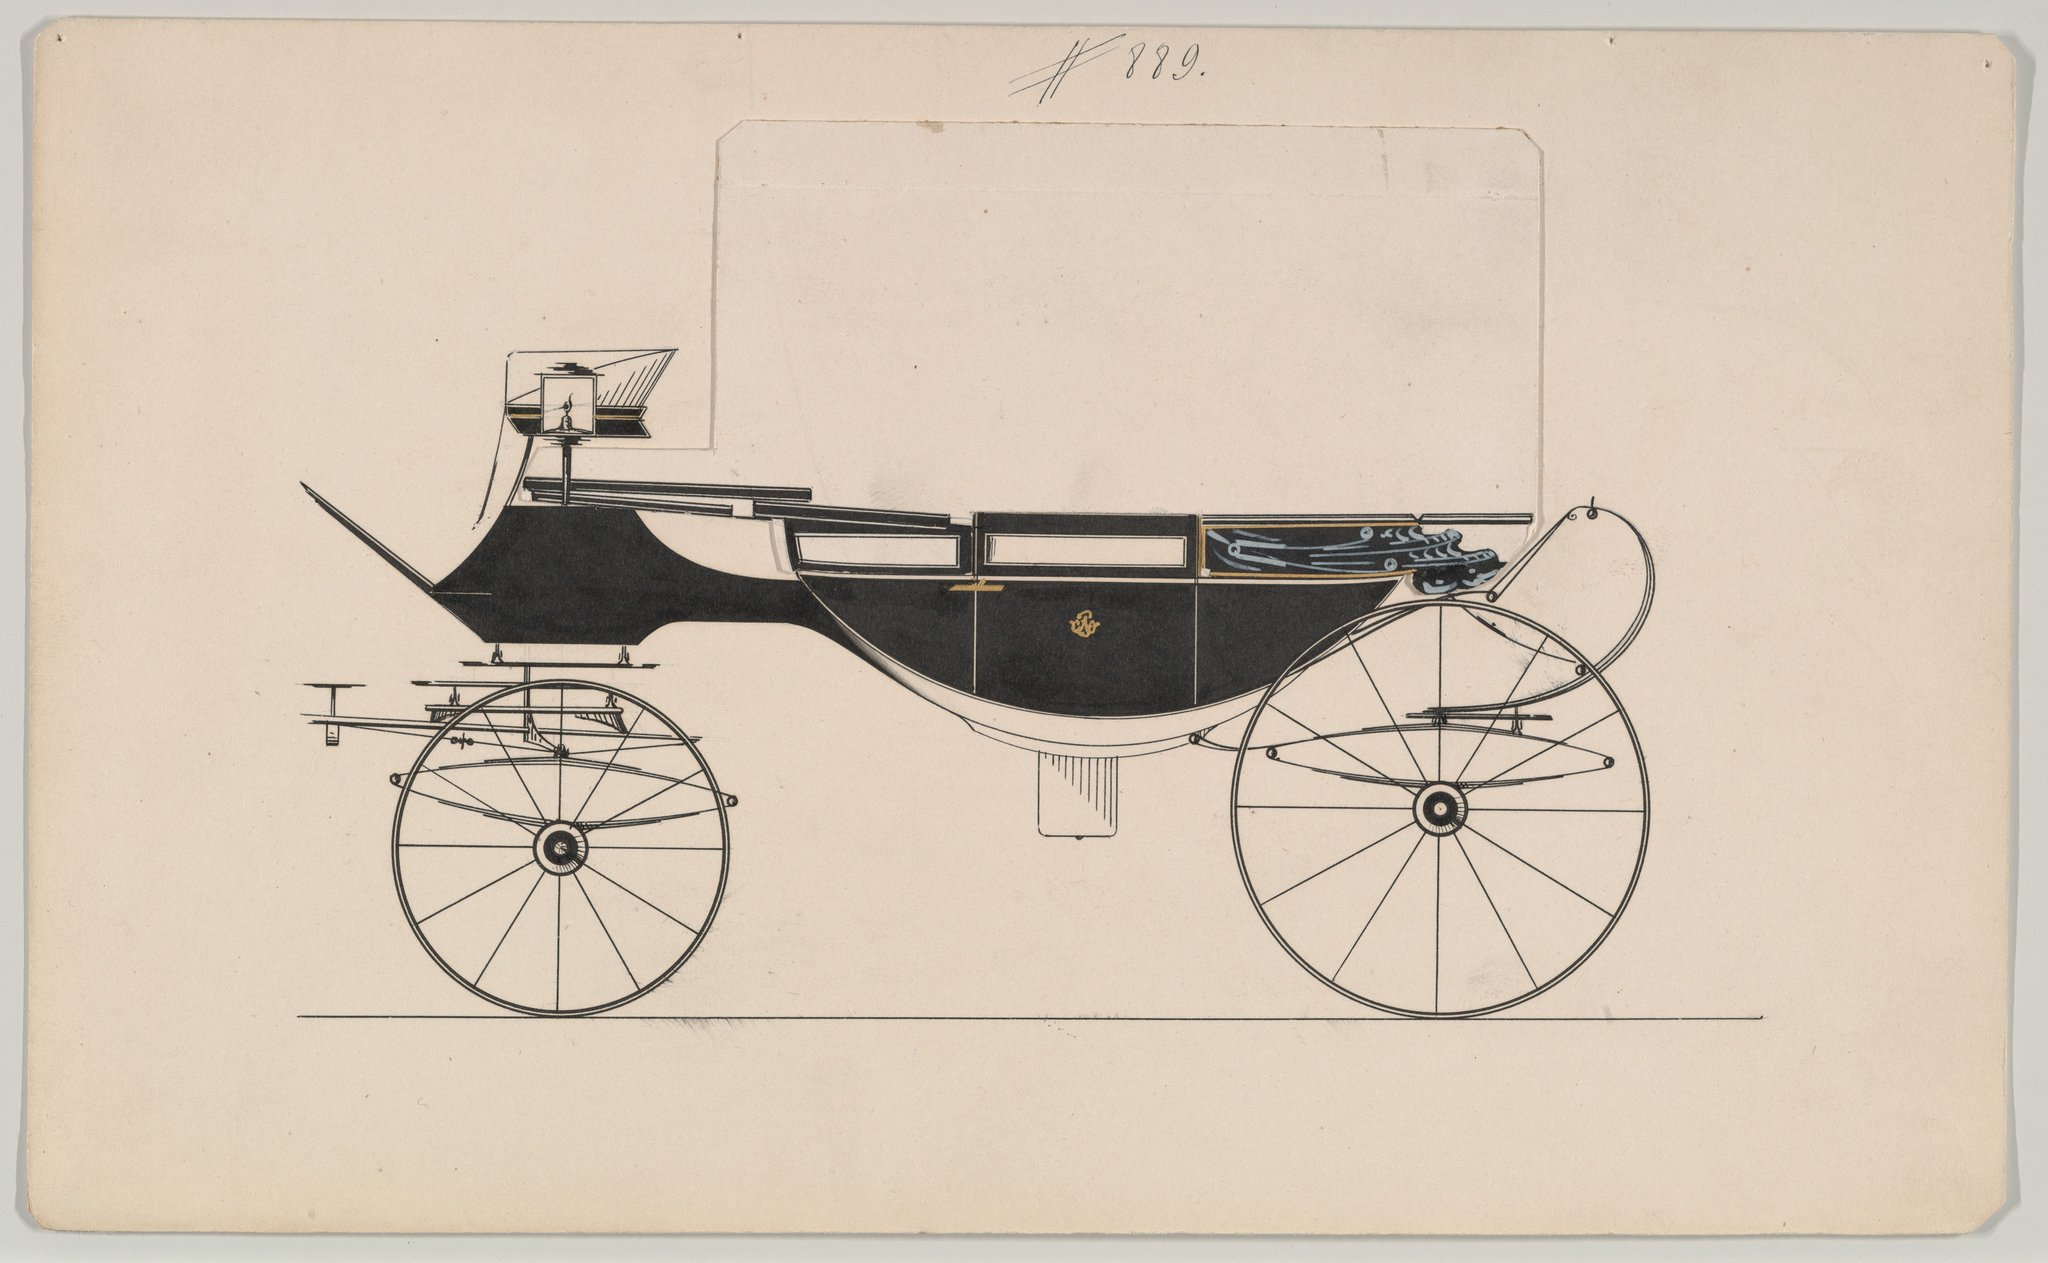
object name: drawing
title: Landau #889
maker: brewster & co.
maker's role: manufacturer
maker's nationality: american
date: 1850-1870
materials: gouache, ink, watercolor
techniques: pen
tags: carriages